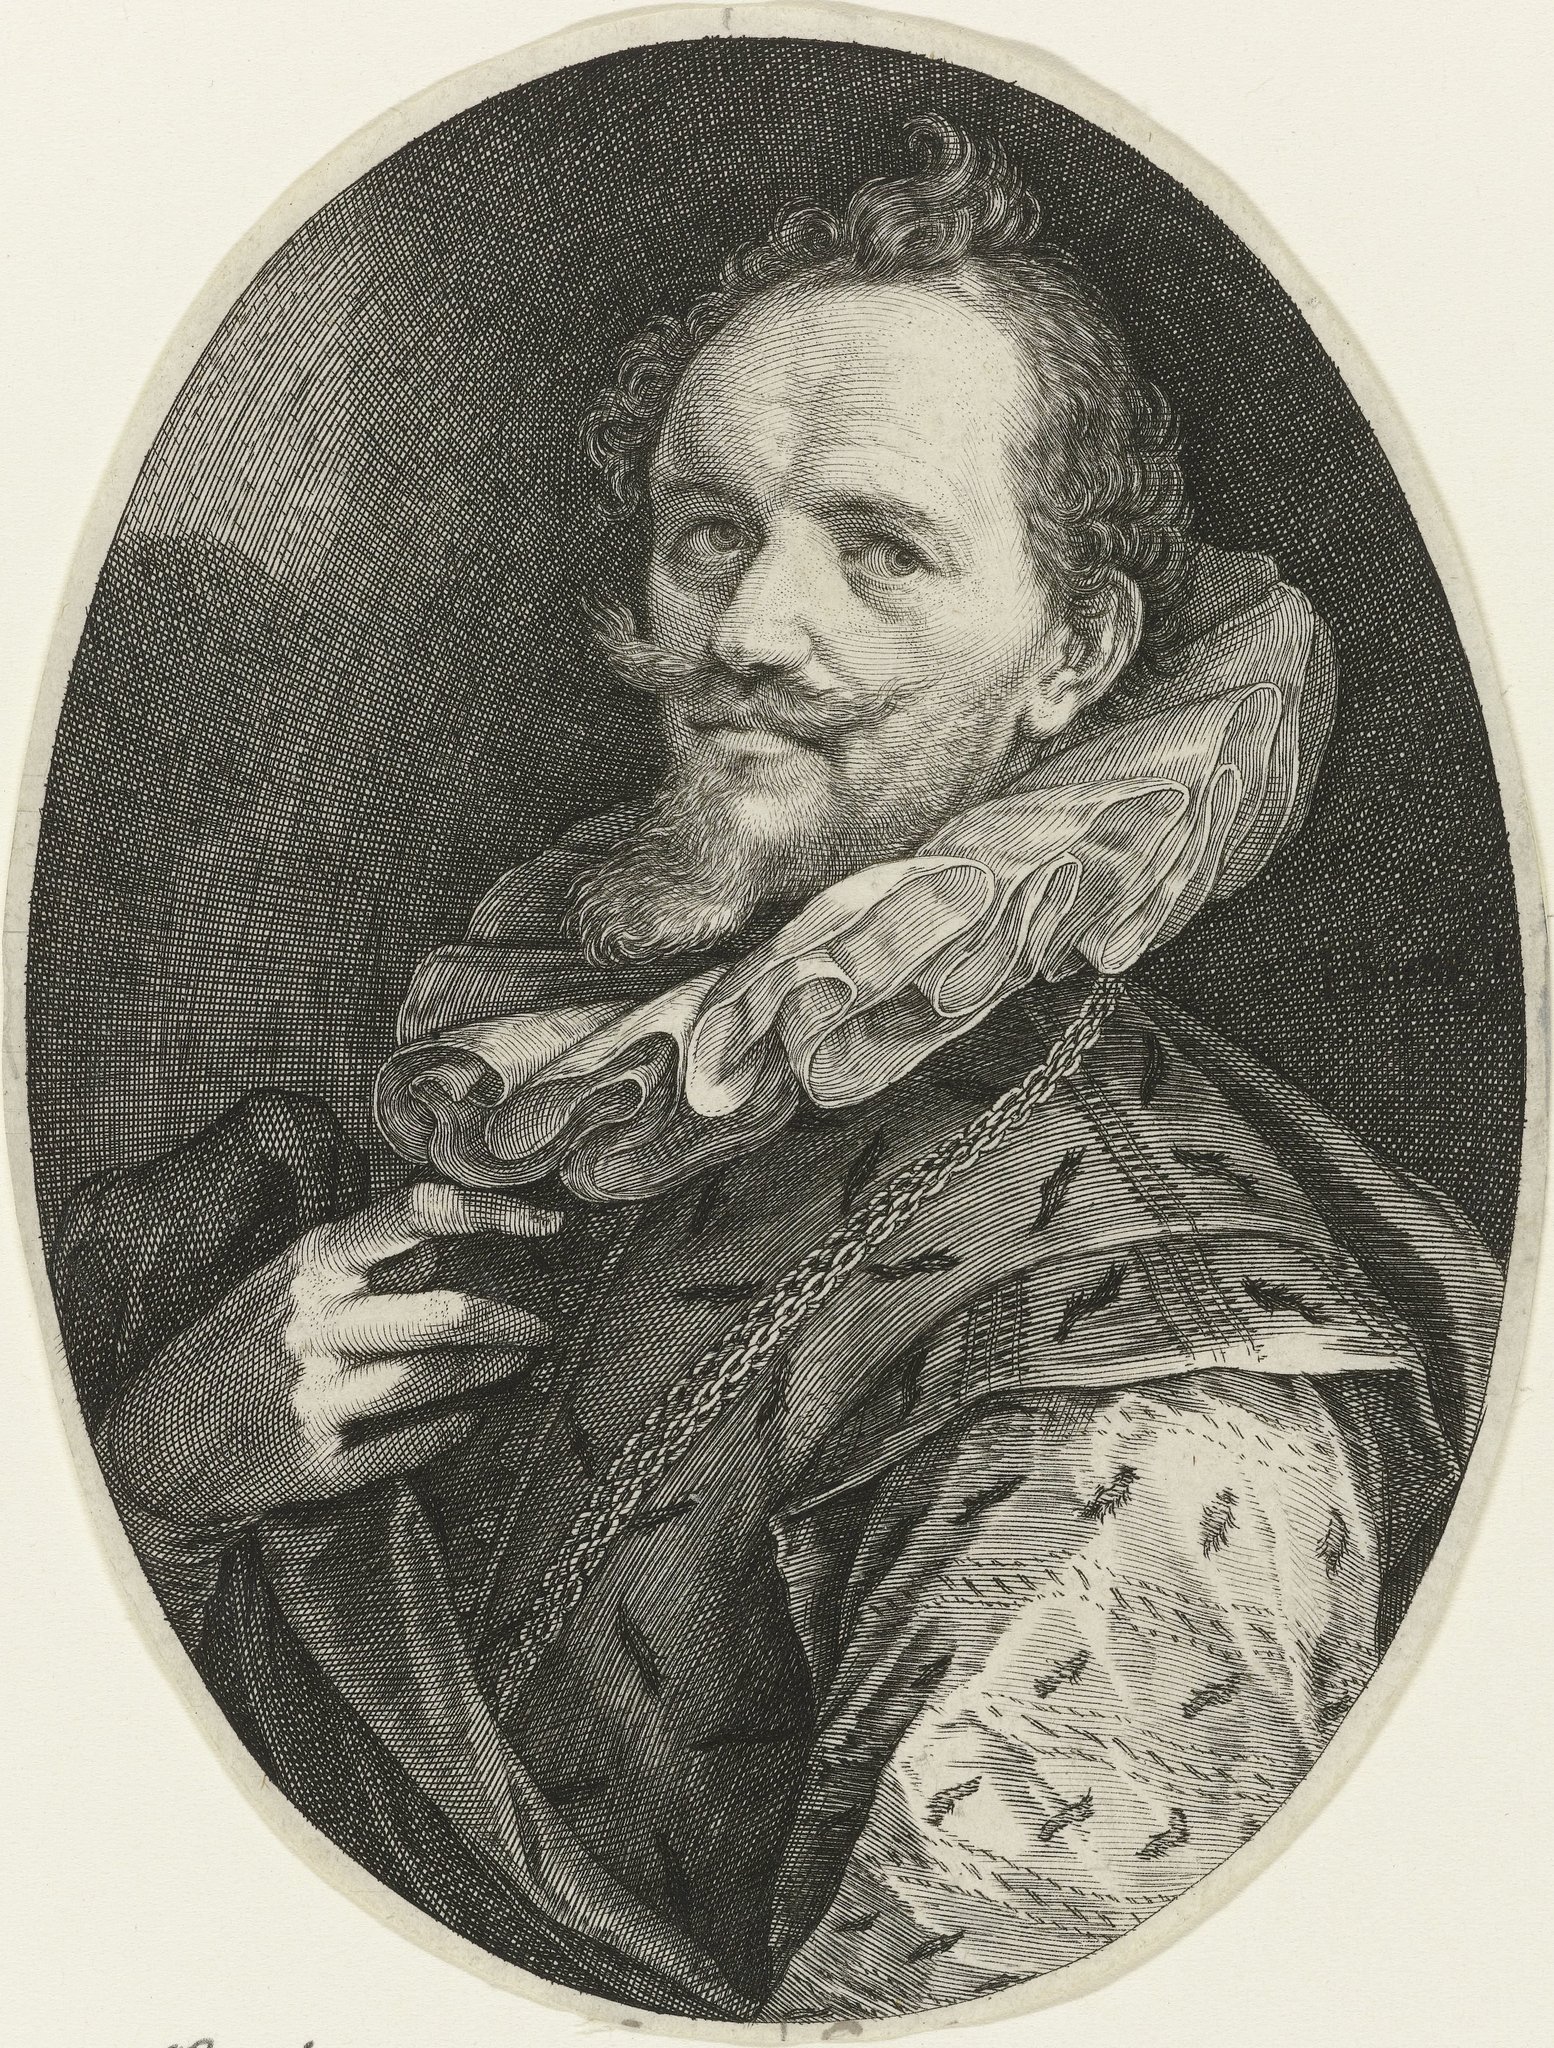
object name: print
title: Portret van Hans von Aachen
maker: jan saenredam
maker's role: draughtsman, print maker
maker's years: 1565-1607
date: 1601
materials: paper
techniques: engraving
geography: amsterdam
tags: prague, hans von aachen, portrait, self-portrait of painter (+ portrait, self-portrait of artist)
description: Buste naar links van de kunstenaar Hans von Aachen met een plooikraag in een ovale omlijsting. Hij houdt zijn rechterhand voor zijn borst.